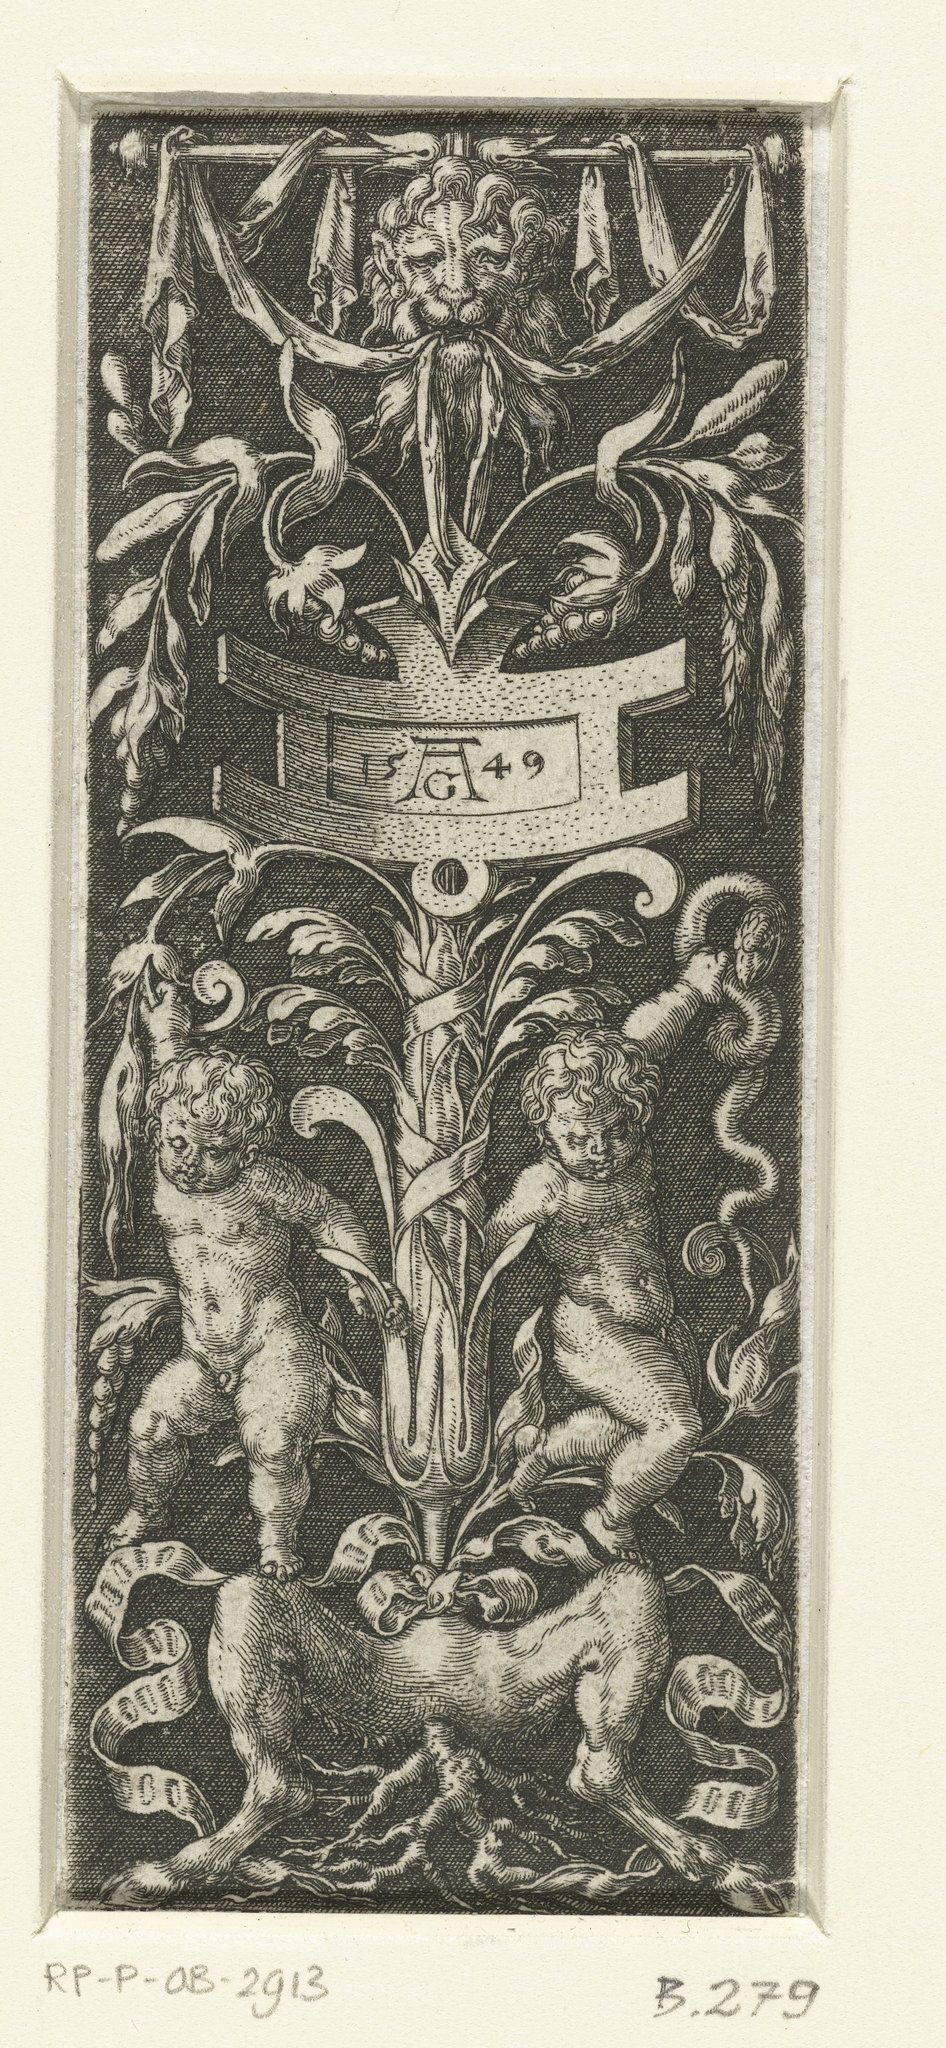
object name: print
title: Vlakdecoratie met twee kinderen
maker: heinrich aldegrever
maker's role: draughtsman, print maker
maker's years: 1502-1561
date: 1549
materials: paper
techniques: engraving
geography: germany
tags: ornaments ~ art, child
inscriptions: number: ‘24’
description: Vlakdecoratie met onderaan de benen van een gehurkte sater, op elk knie staat een kind. Het rechter kind heeft een slang in zijn hand. In het midden een cartouche en daarboven een leeuwenkop